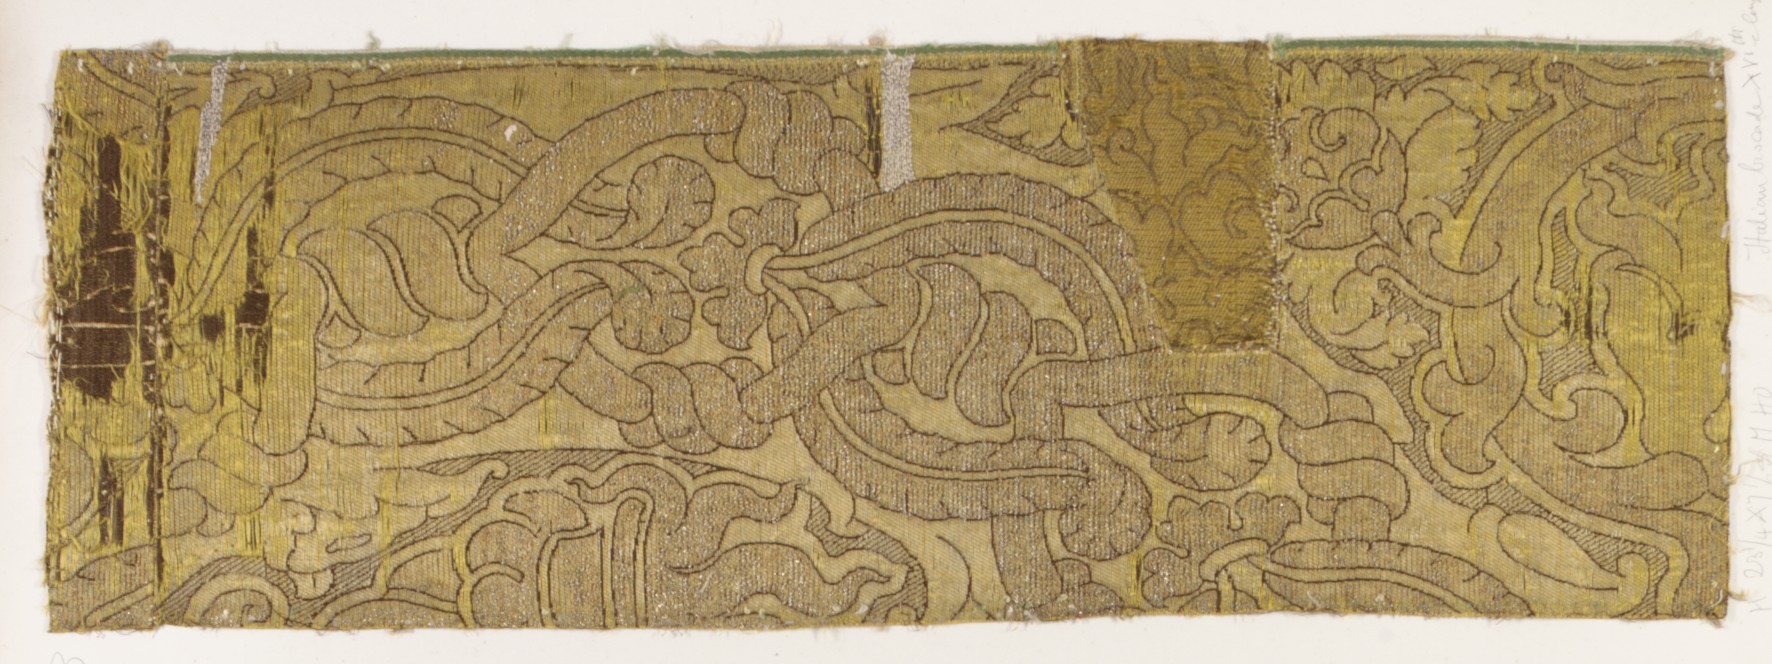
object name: fragment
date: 1501-1600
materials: metal thread, silk